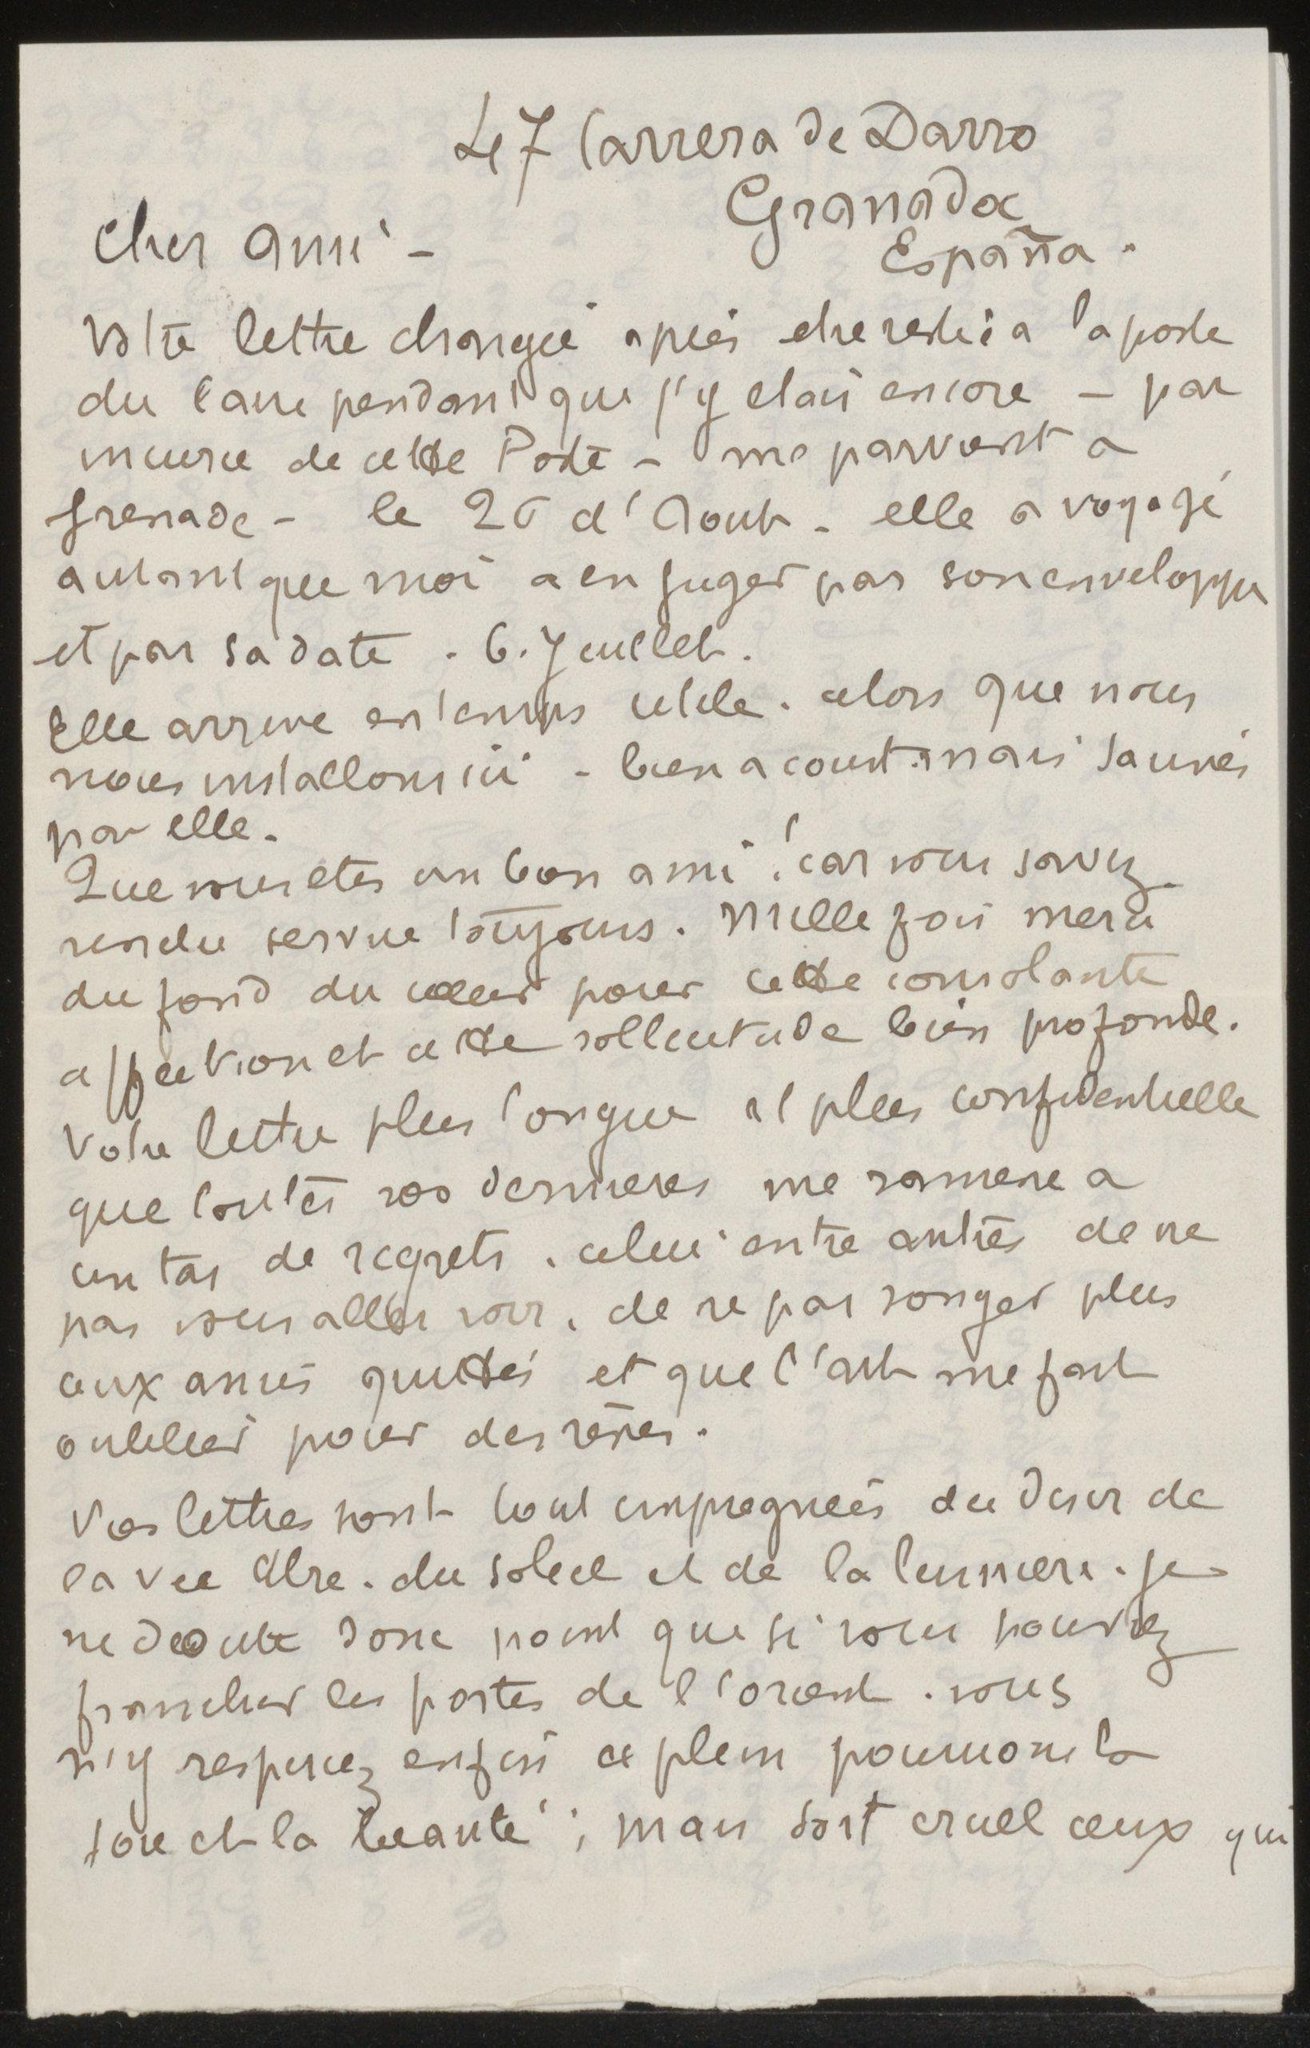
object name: letter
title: Brief aan Andries Bonger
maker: émile bernard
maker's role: print maker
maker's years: 1868-1941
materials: ink, paper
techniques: pen, writing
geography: granada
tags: venice, painter, print maker, draughtsman, canaletto, sevilla, bartolomé esteban murillo, rome, rafaël, brussels, pieter bruegel (i), diego rodriguez de silva y velázquez, correggio, francisco de goya, leiden, amsterdam, rembrandt van rijn, jusepe de ribera, titiaan, andries bonger, artist, leonardo da vinci, sculpture, painting (including book-illumination, miniature-painting), architecture, naples